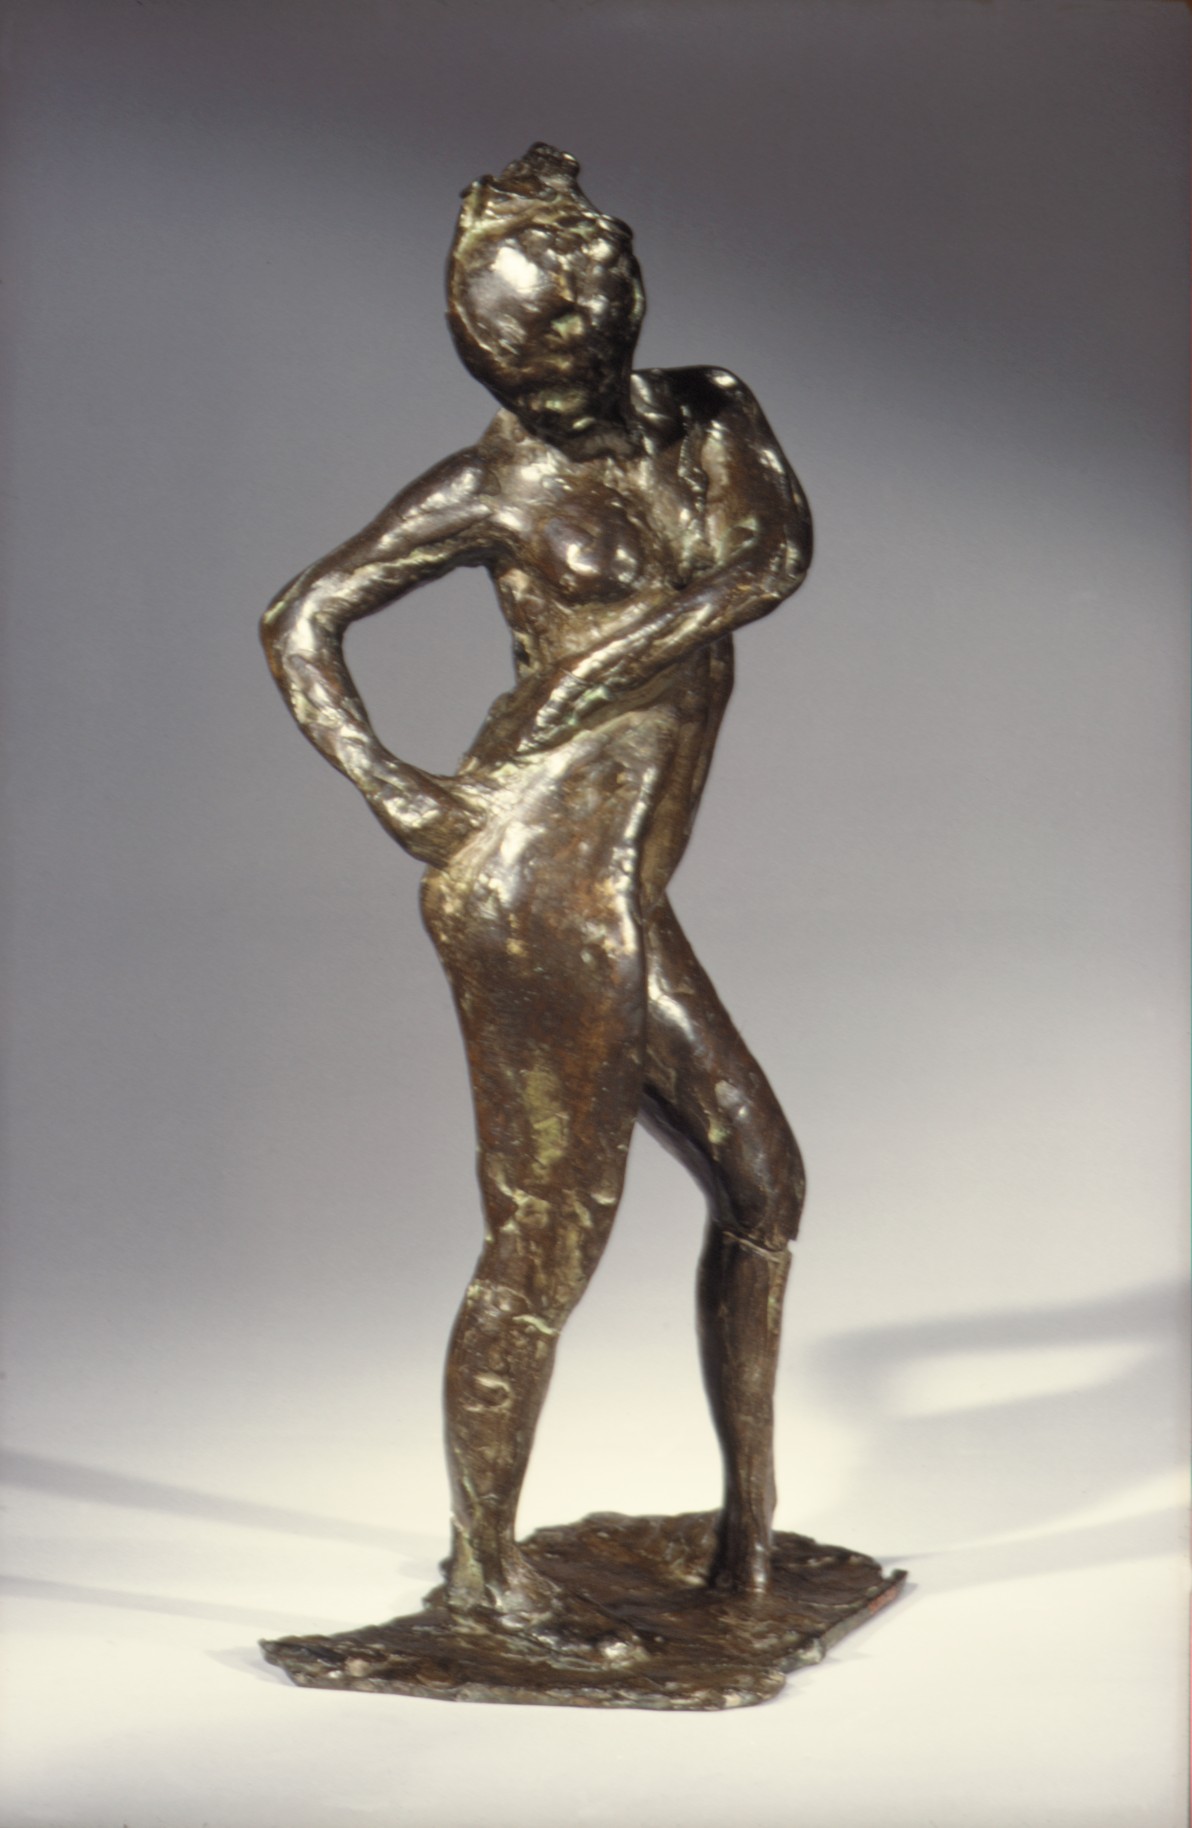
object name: statuette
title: Dancer Fastening the String of Her Tights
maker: edgar degas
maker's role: artist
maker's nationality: french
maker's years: 1834-1917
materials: bronze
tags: female nudes,dancers